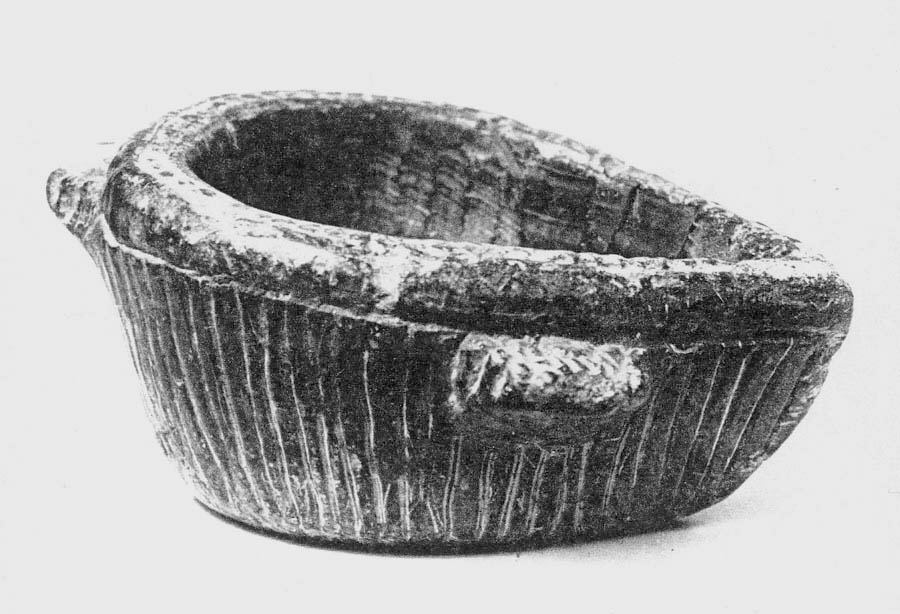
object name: lamp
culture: indian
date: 1-300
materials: stone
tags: shunga